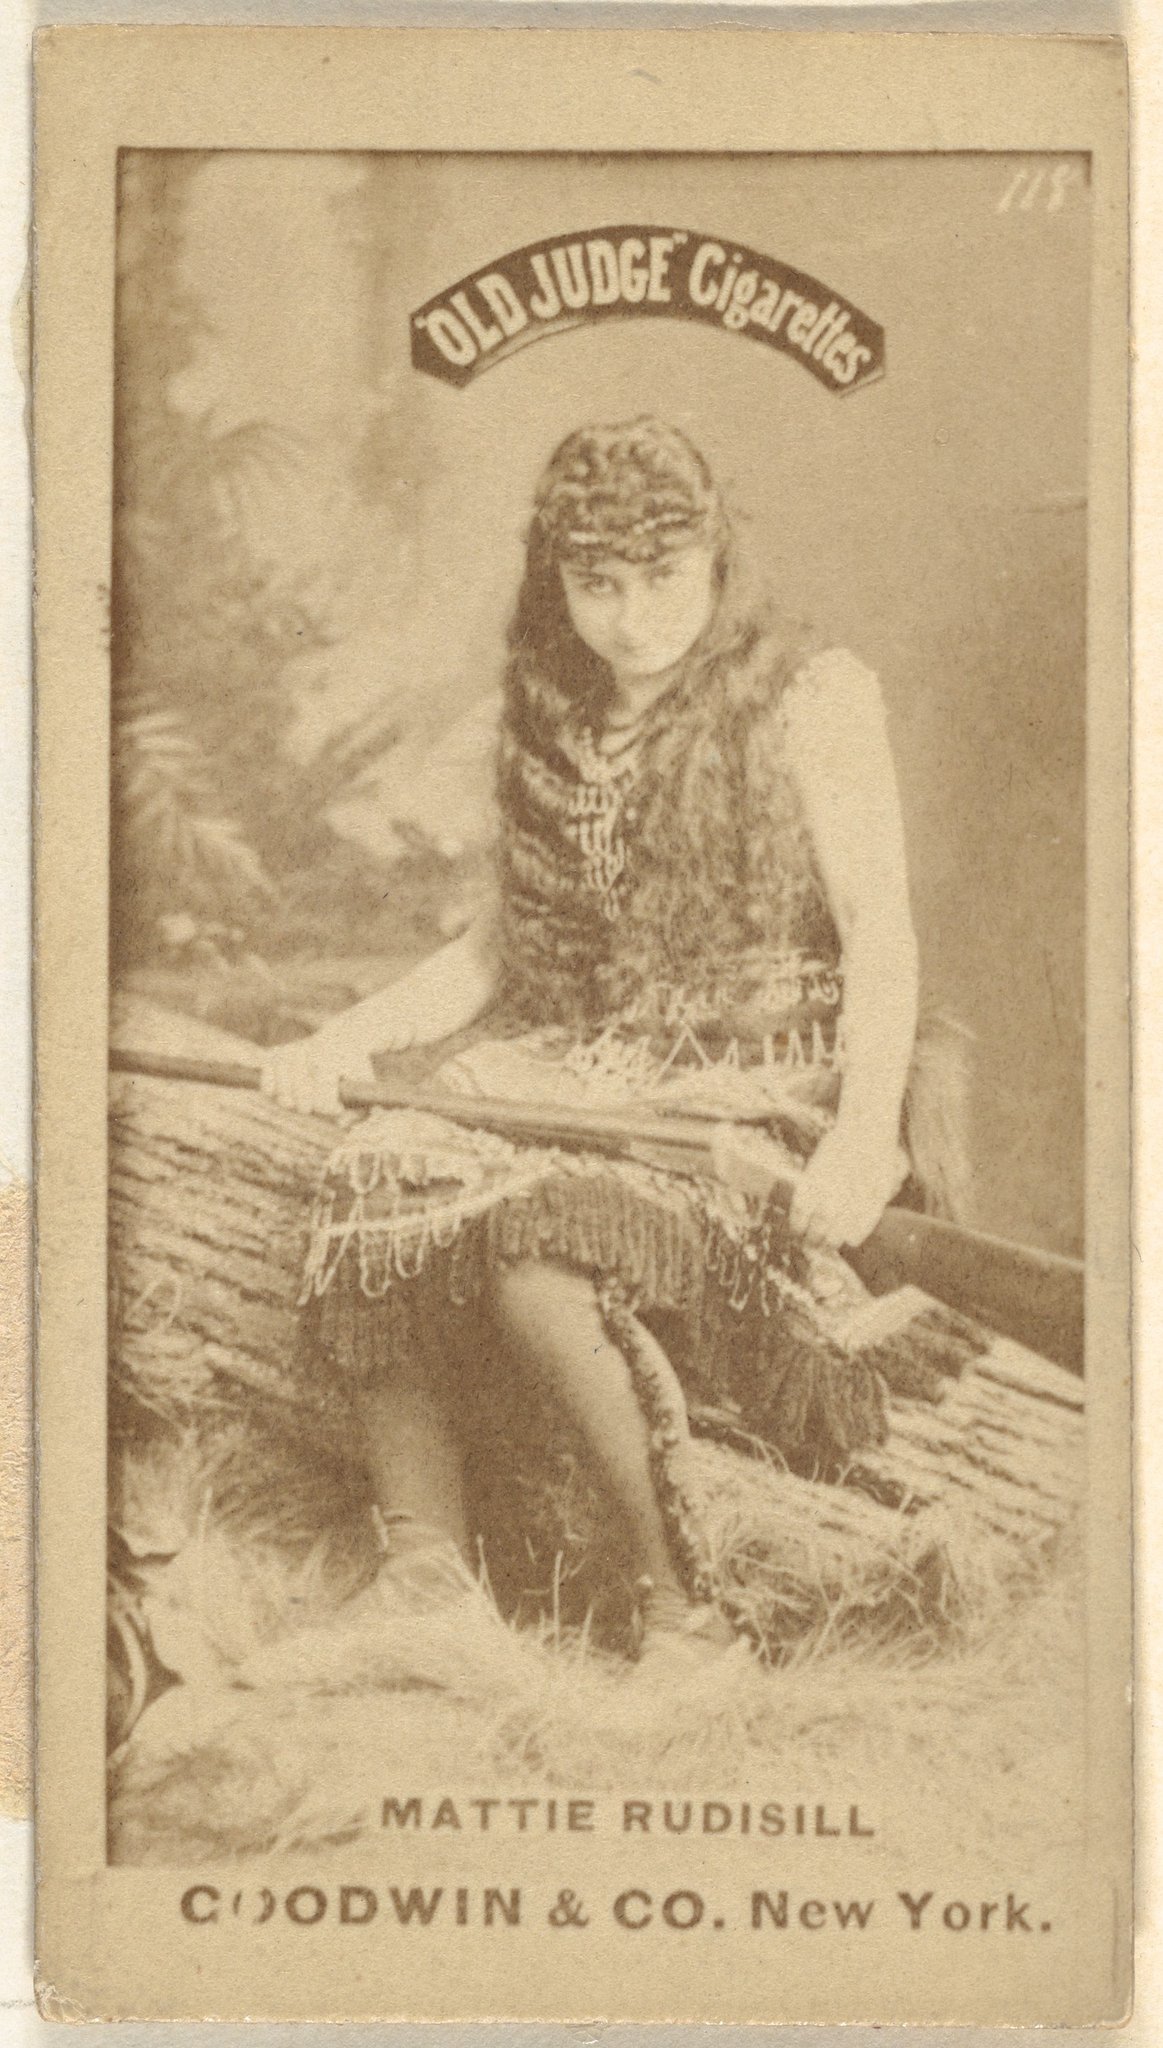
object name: photograph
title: Mattie Rudisill, from the Actors and Actresses series (N171) for Old Judge Cigarettes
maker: goodwin & company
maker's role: publisher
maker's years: 1850-1950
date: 1886-1890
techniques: albumen silver print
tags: firearms,women,actresses